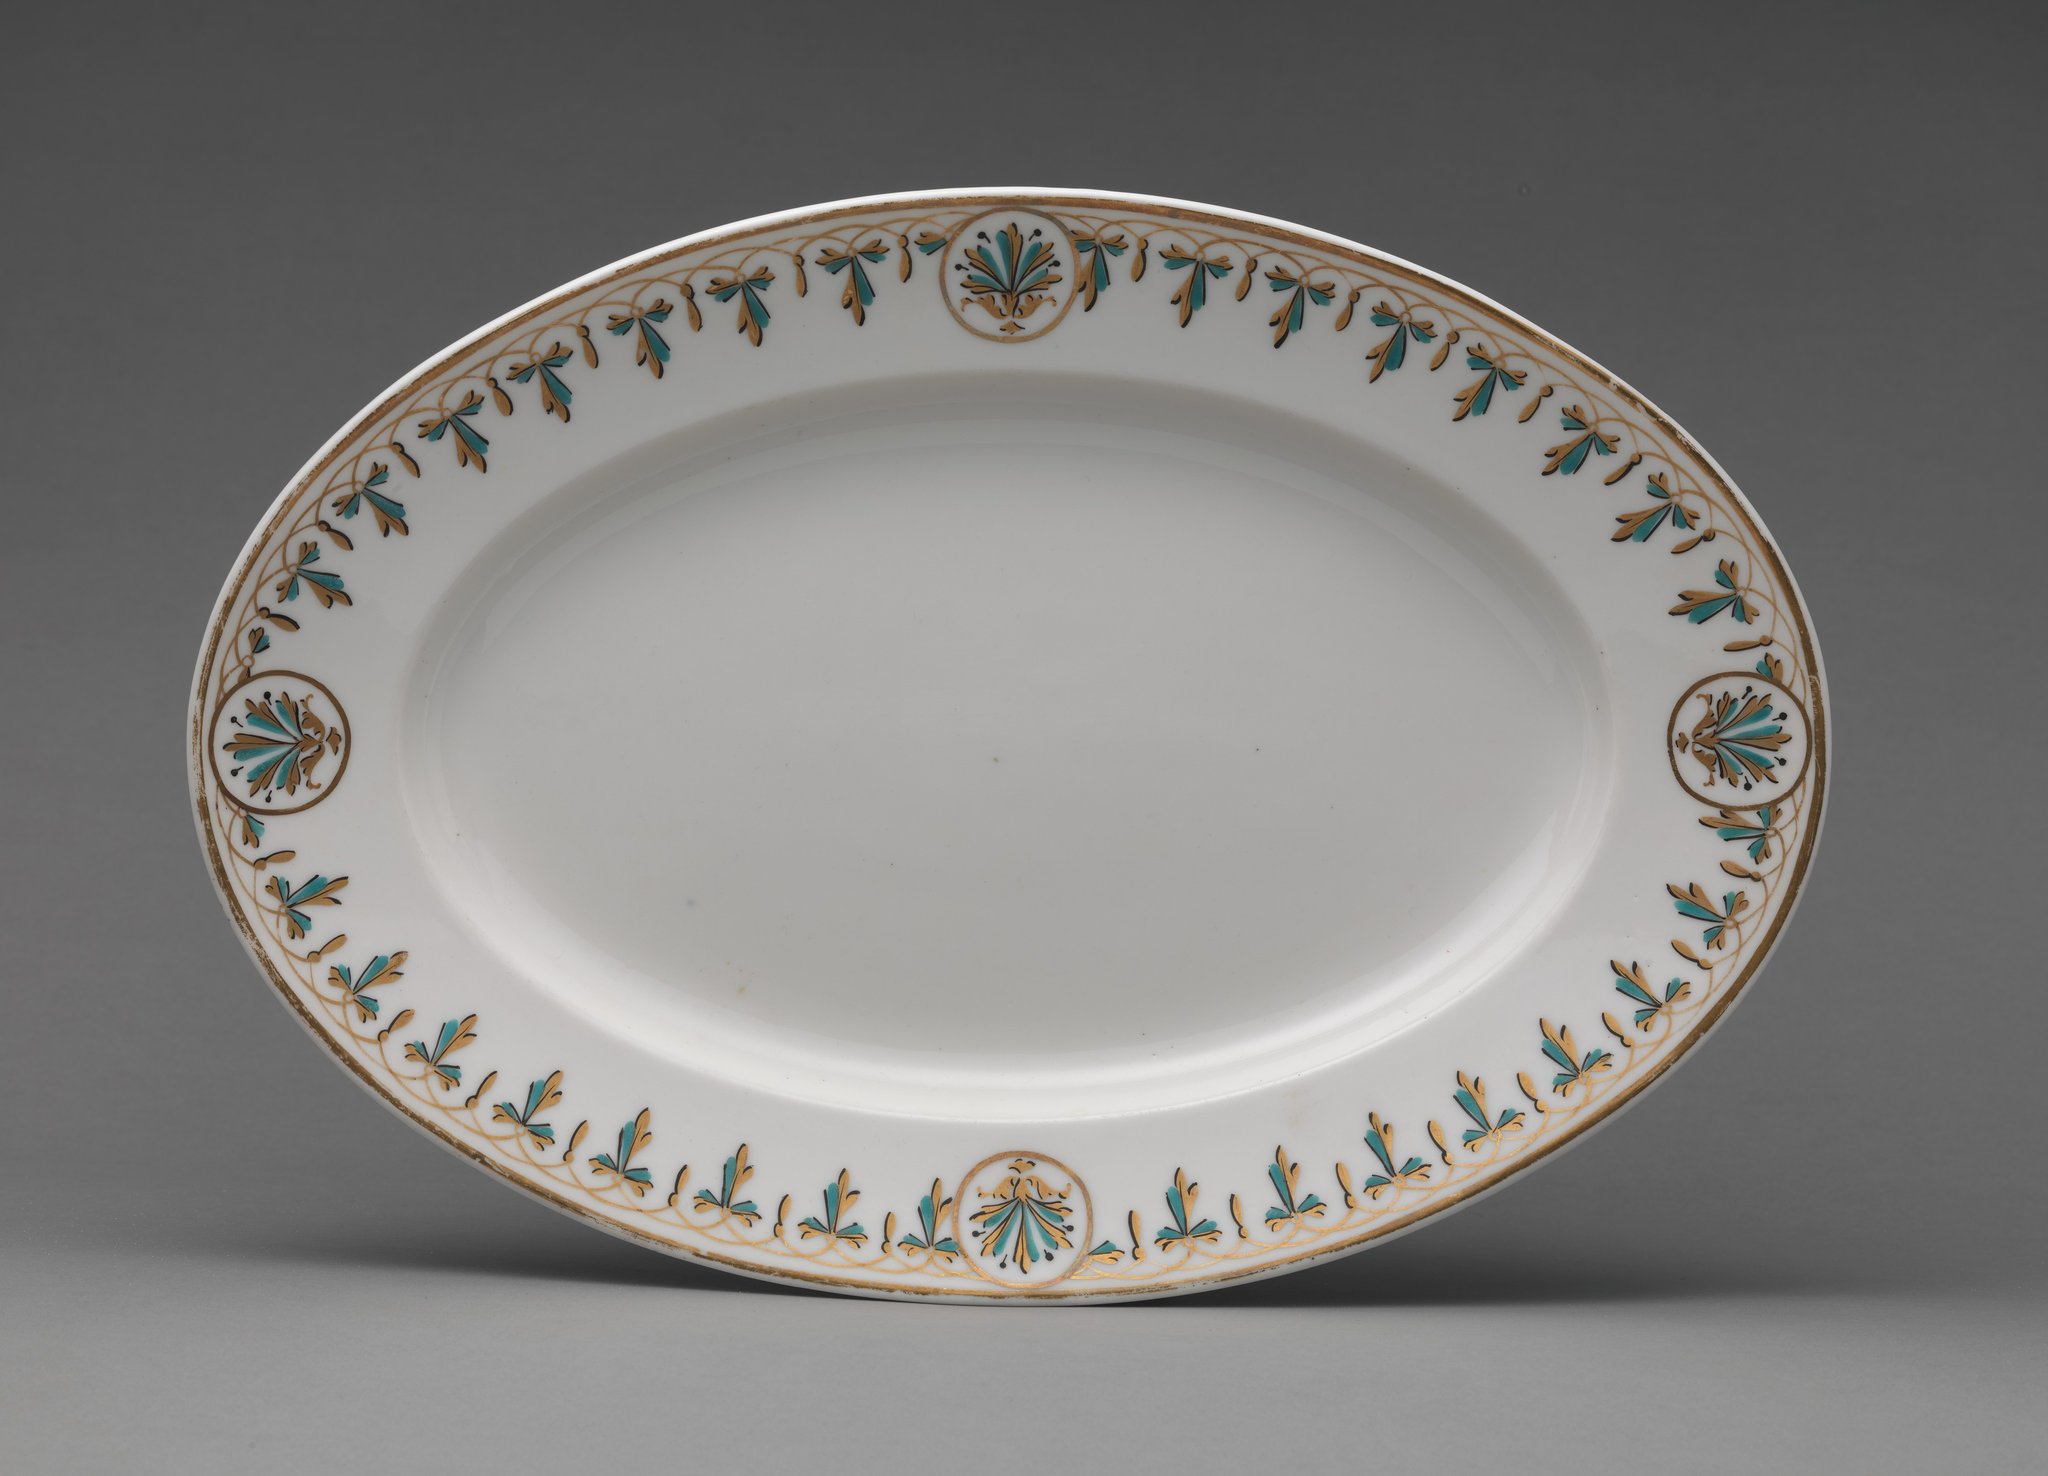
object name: platter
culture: american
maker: union porcelain works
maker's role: maker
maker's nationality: american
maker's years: 1863-1922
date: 1885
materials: porcelain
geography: united states